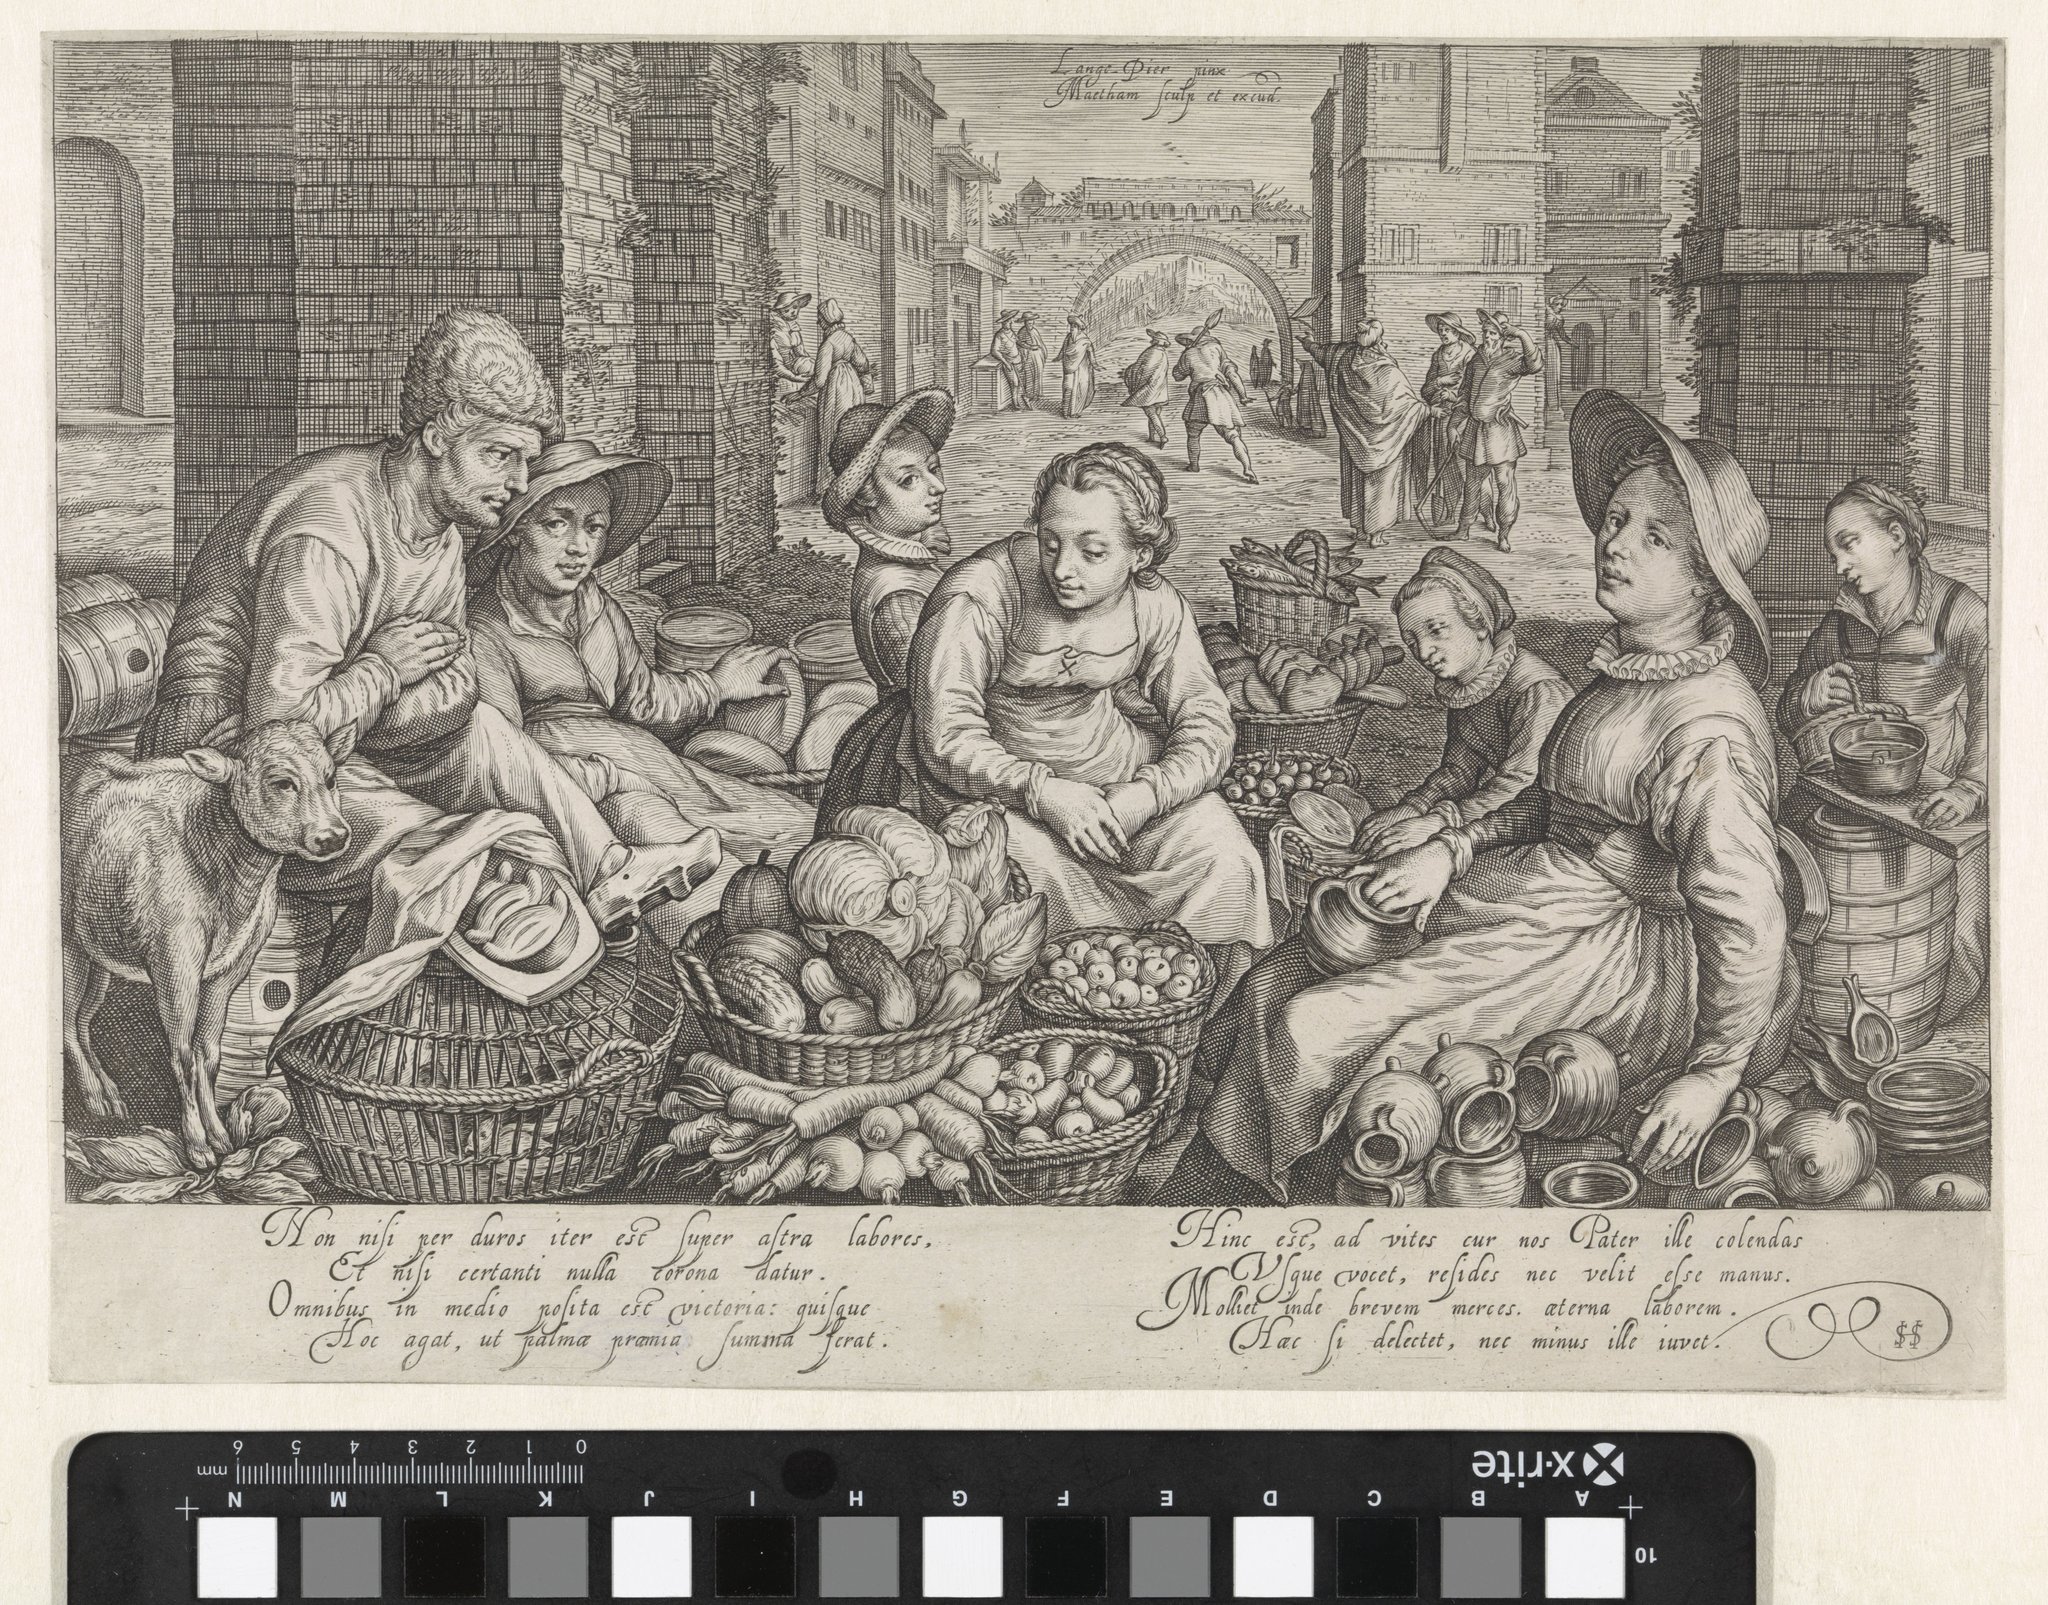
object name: print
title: Marktstuk met de parabel van de heer van de wijngaard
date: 1603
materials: paper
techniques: engraving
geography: haarlem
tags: the labourers in the vineyard ~ parable of christ (matthew 20:1-16), market, foodstuffs; still life of foodstuffs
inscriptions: collector's mark: Lugt 2228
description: Een gezelschap bij uitgestalde groenten. Rechts een vrouw met aardewerk potten. Op de achtergrond de arbeiders die op het plein worden aangesproken: een scène uit de parabel van de heer van wijngaard (Matt. 20:1-16). Prent uit een serie van vijf prenten met keuken- en marktstukken gecombineerd met bijbelse scènes in de achtergrond.